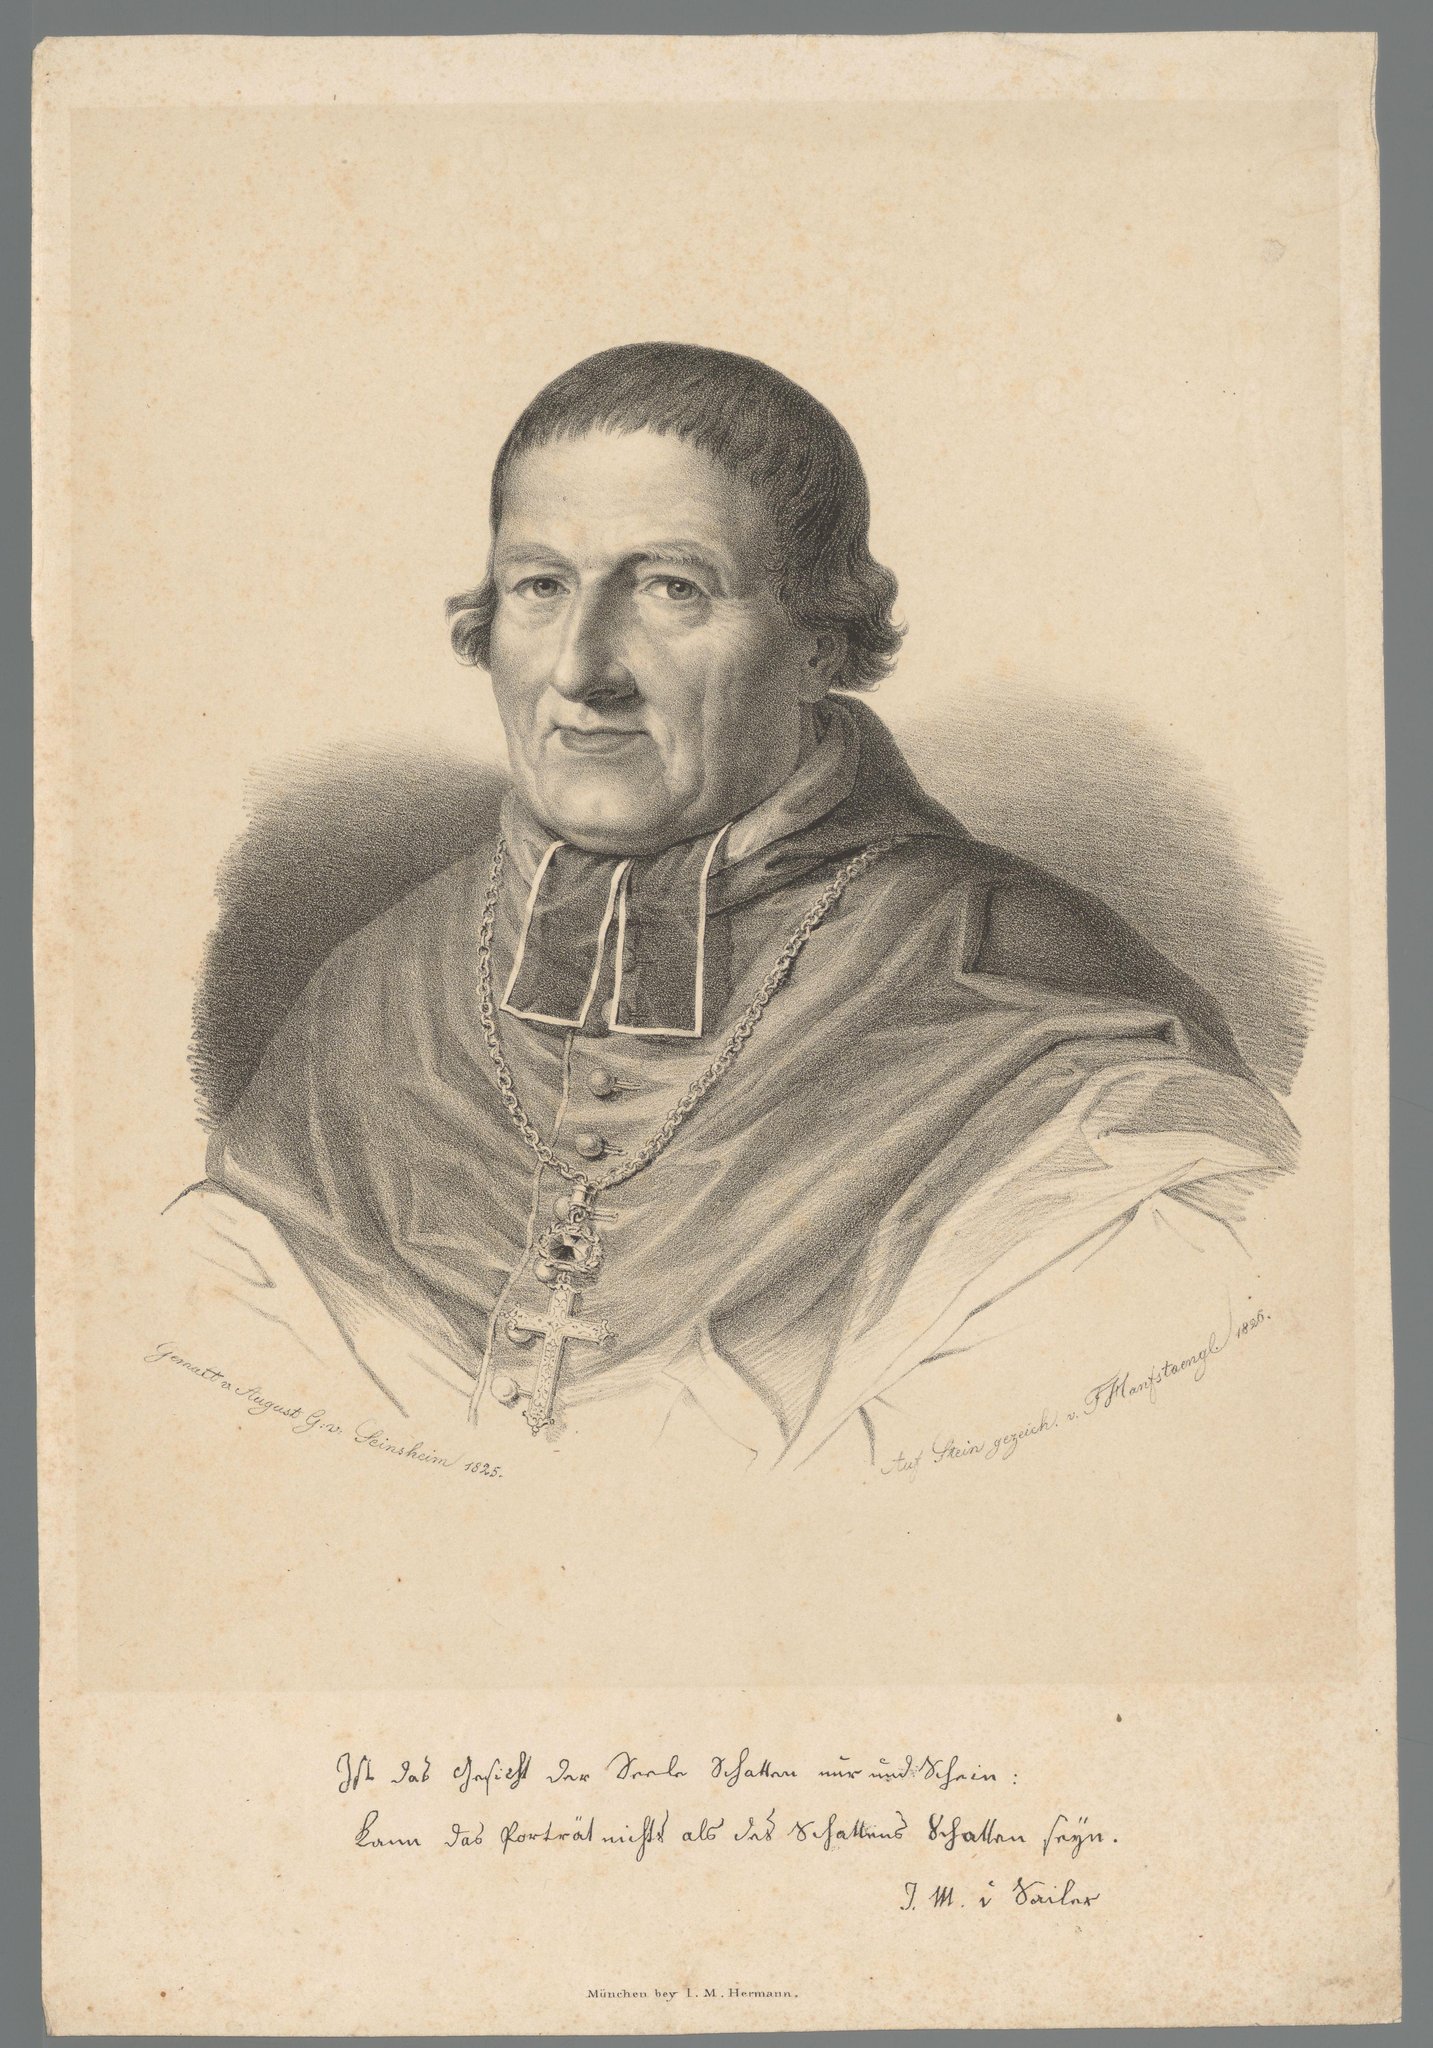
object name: print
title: Portret van Johann Michael Sailer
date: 1826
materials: paper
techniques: tone lithography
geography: munich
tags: adult man, historical persons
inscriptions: collector's mark: Lugt 2228